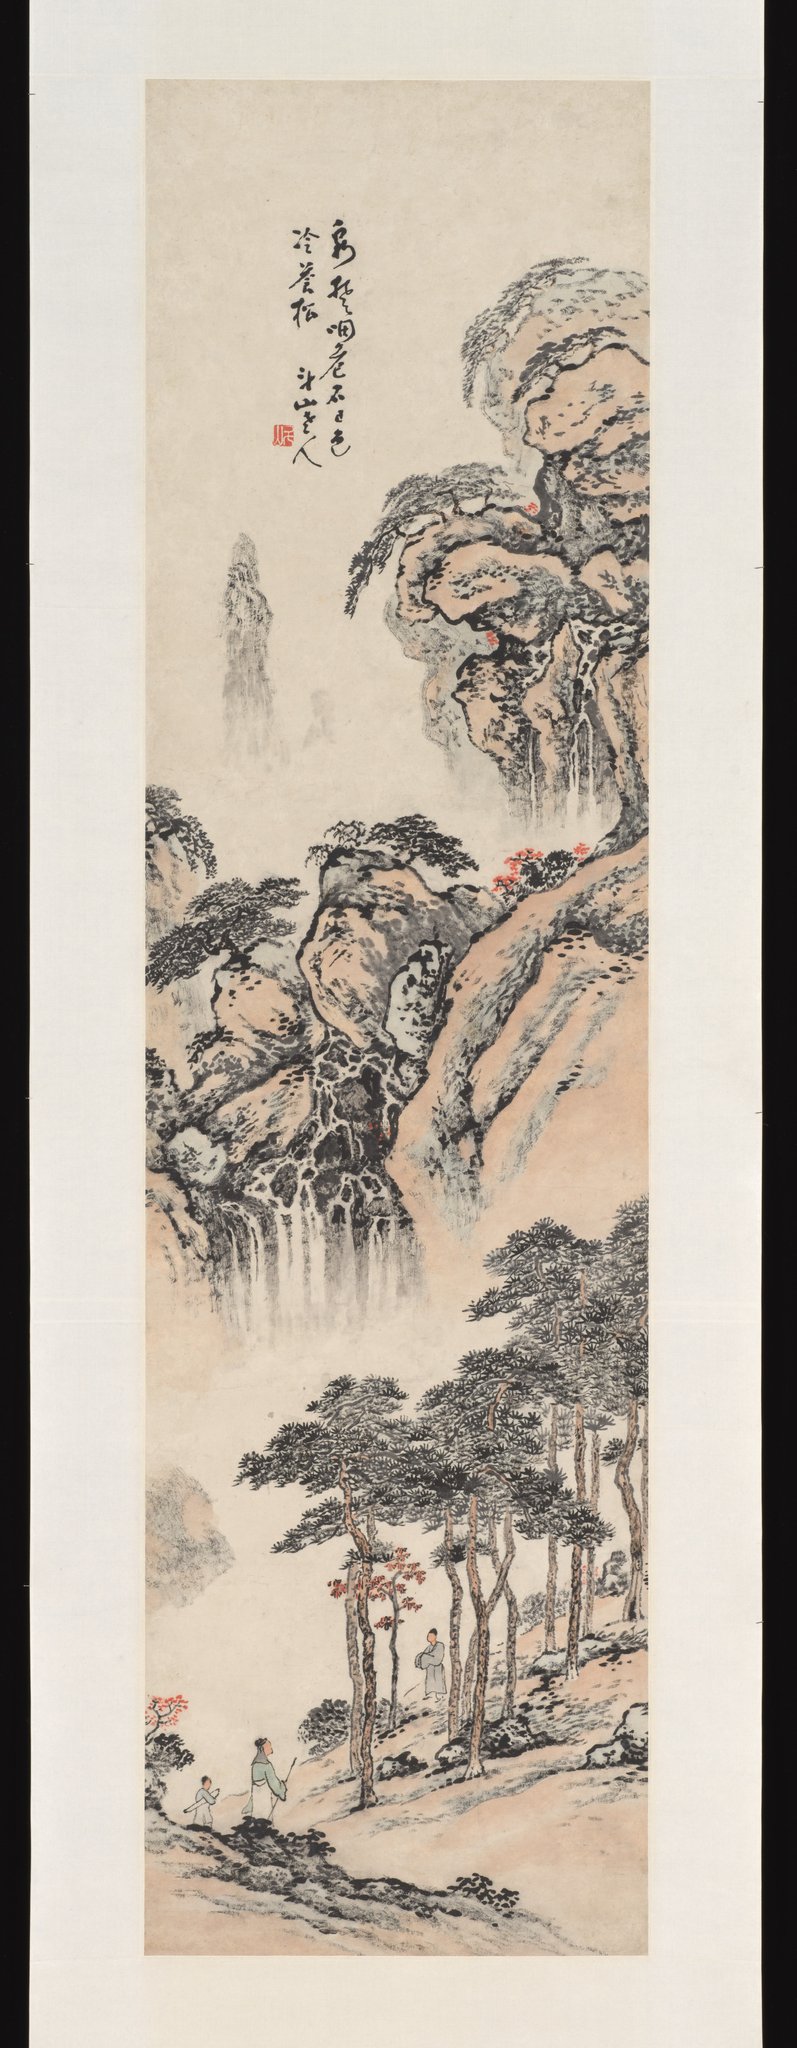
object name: hanging scroll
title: Landscape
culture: chinese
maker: li kui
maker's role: artist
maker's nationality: chinese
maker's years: 1789-1876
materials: ink, paper